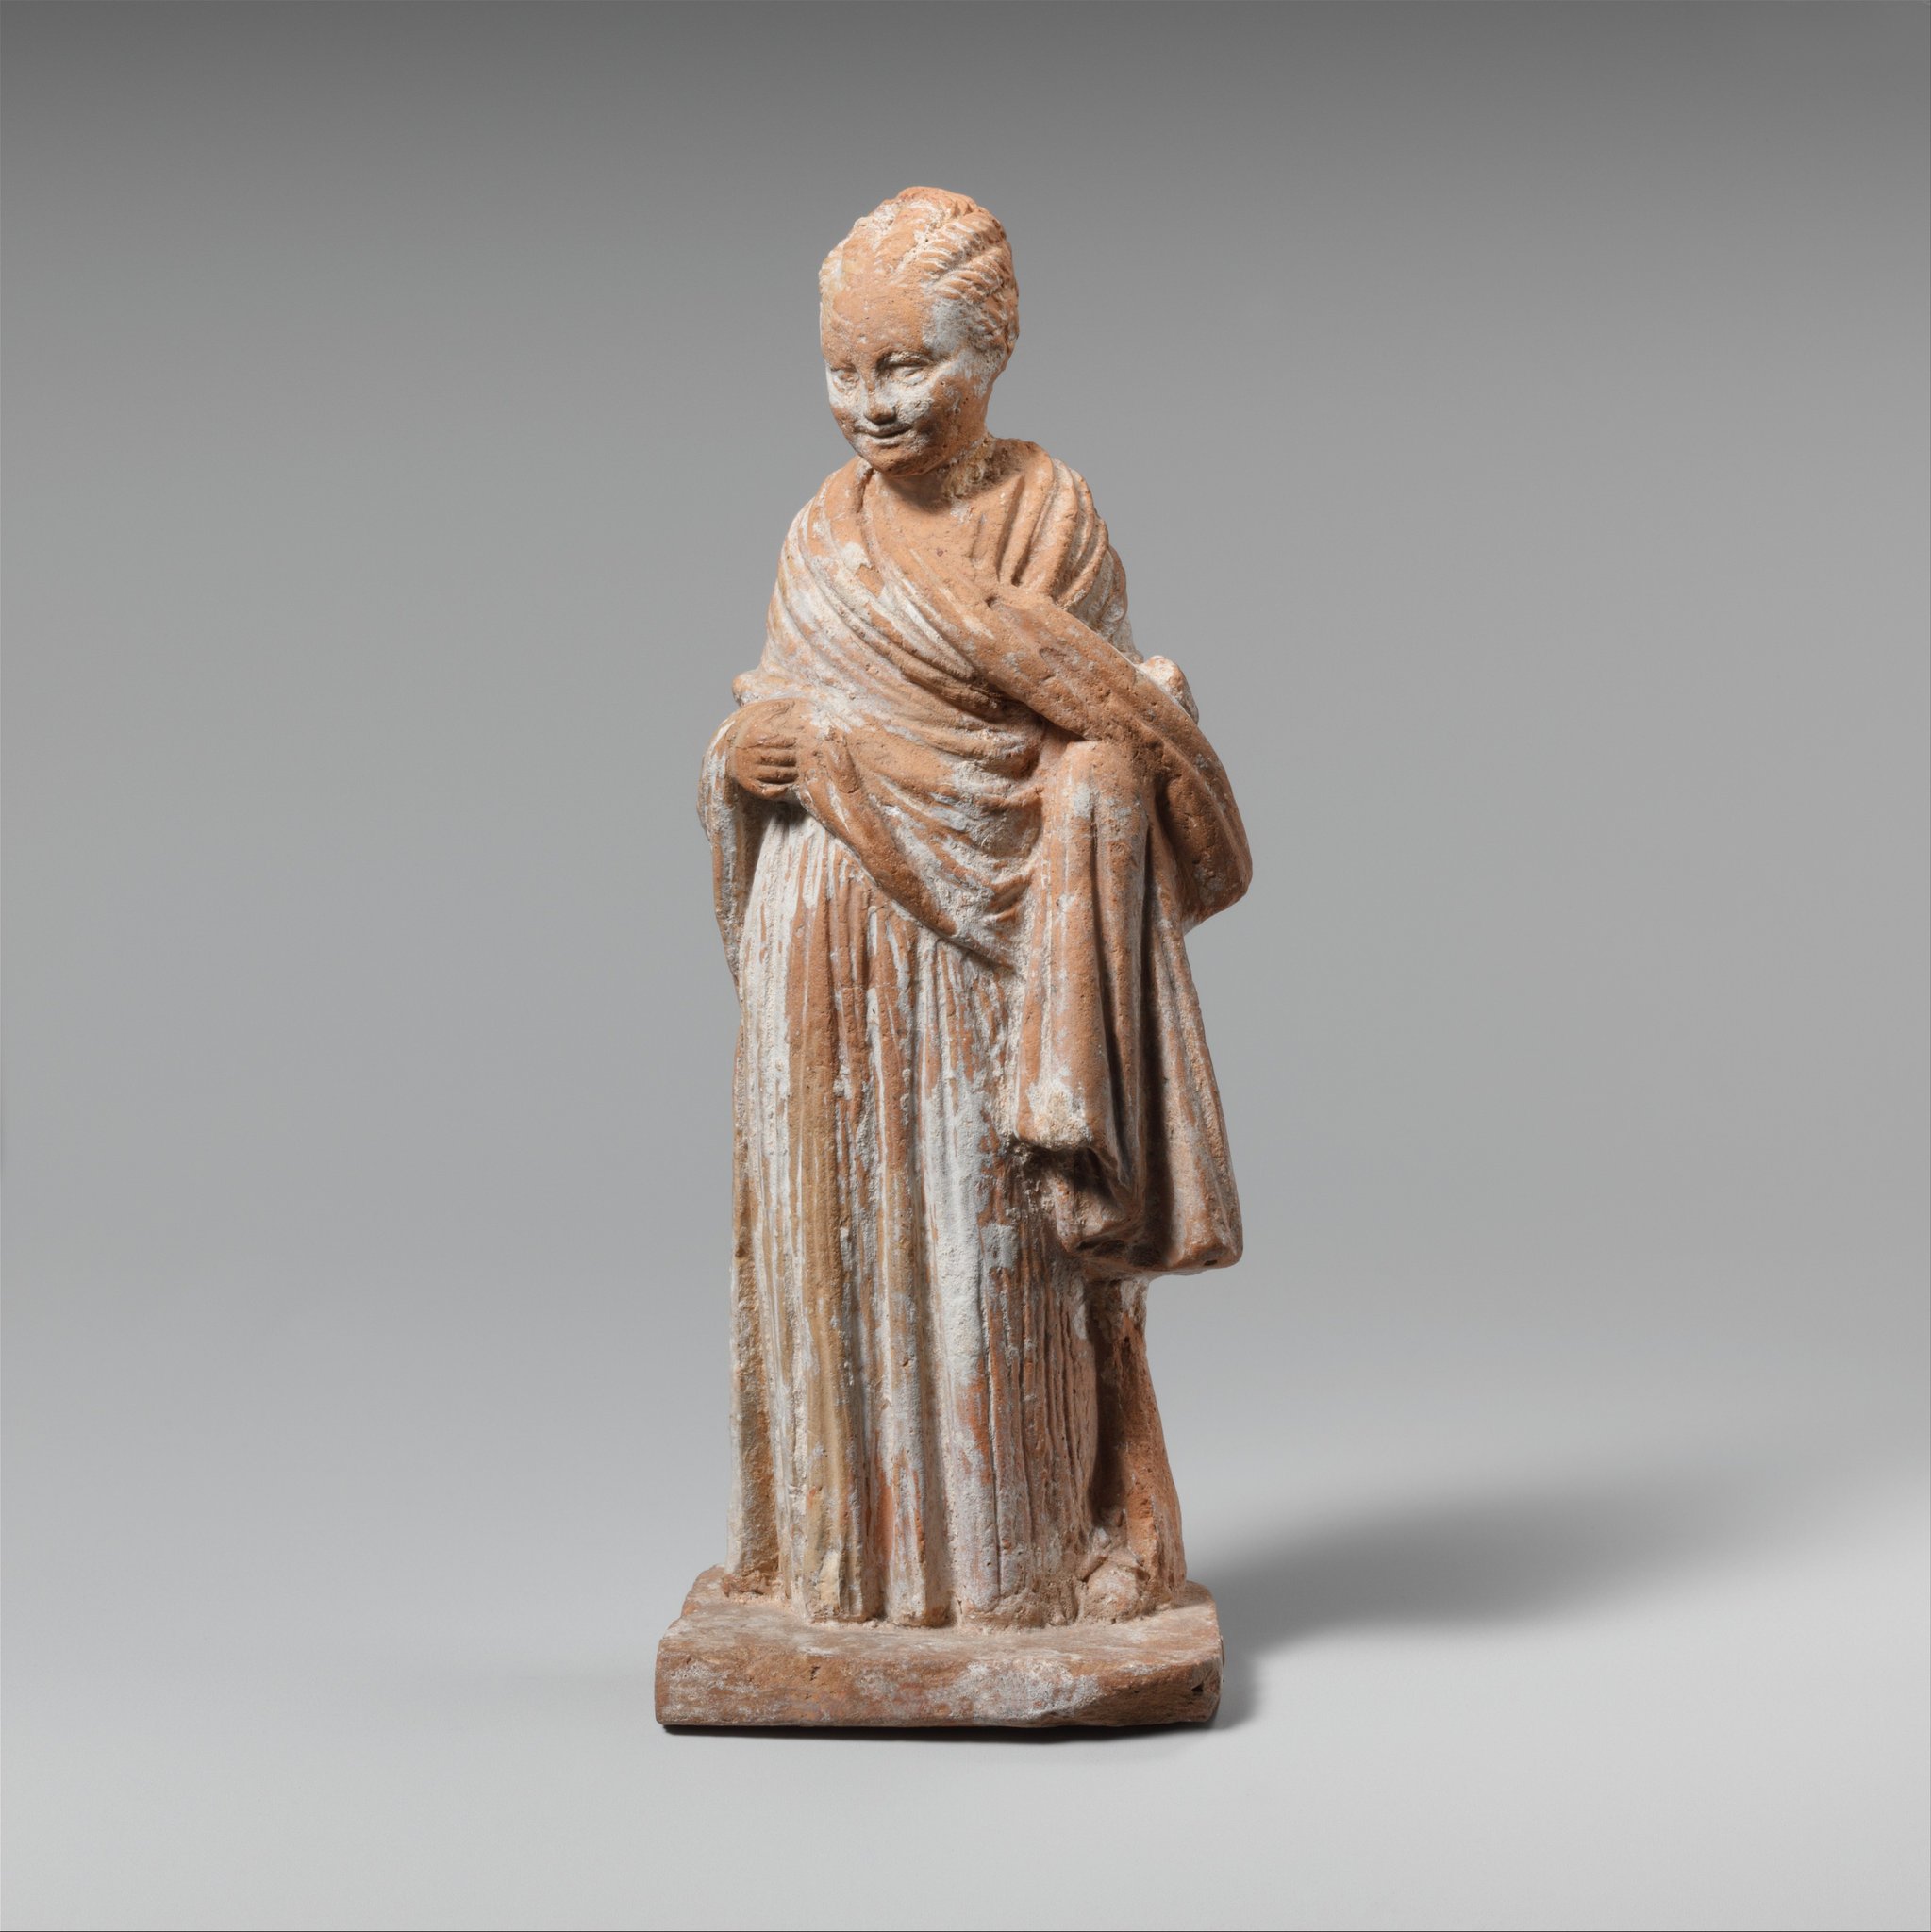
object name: statuette of standing draped girl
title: Terracotta statuette of a standing girl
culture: greek, attic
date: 300 BCE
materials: terracotta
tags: girls